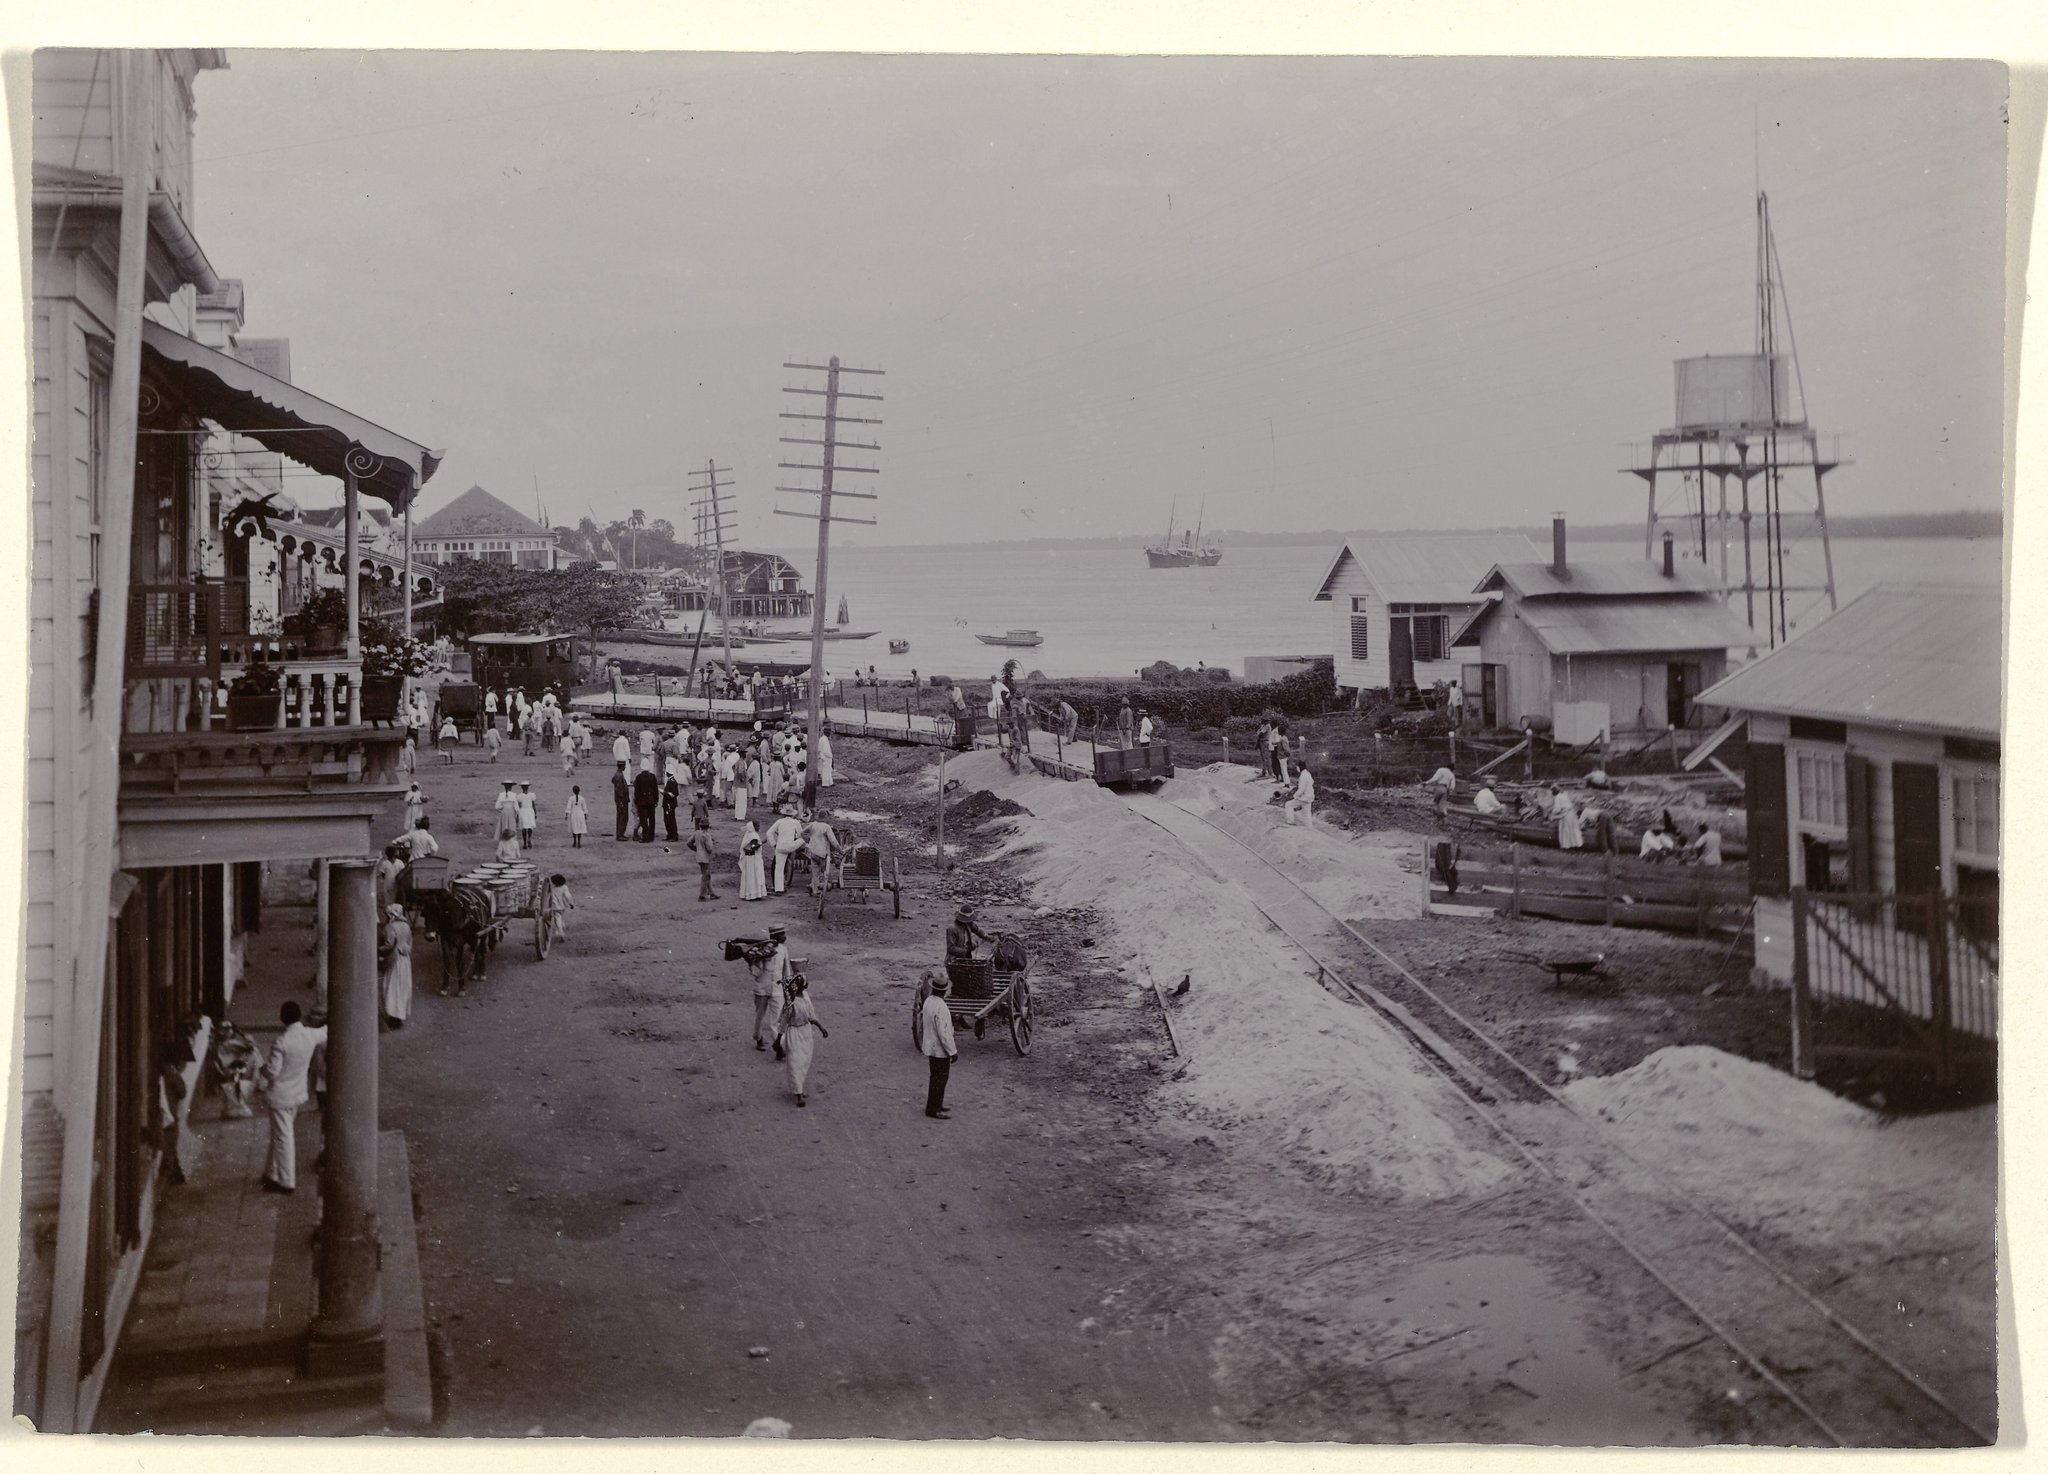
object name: photograph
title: Stadsgezicht in Suriname met spooraanleg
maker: Anonymous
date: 1905-1910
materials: photographic support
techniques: photography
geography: paramaribo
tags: city-view in general; 'veduta', railway, train, suriname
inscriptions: annotation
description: Vermoedelijk de Waterkant in Paramaribo, waar gewerkt wordt aan de aanleg van de spoorlijn, waarschijnlijk de aanleg van de Lawaspoorweg in Suriname in de jaren 1903-1912. Onderdeel van een groep objecten afkomstig van de familie Wesenhagen in Suriname.